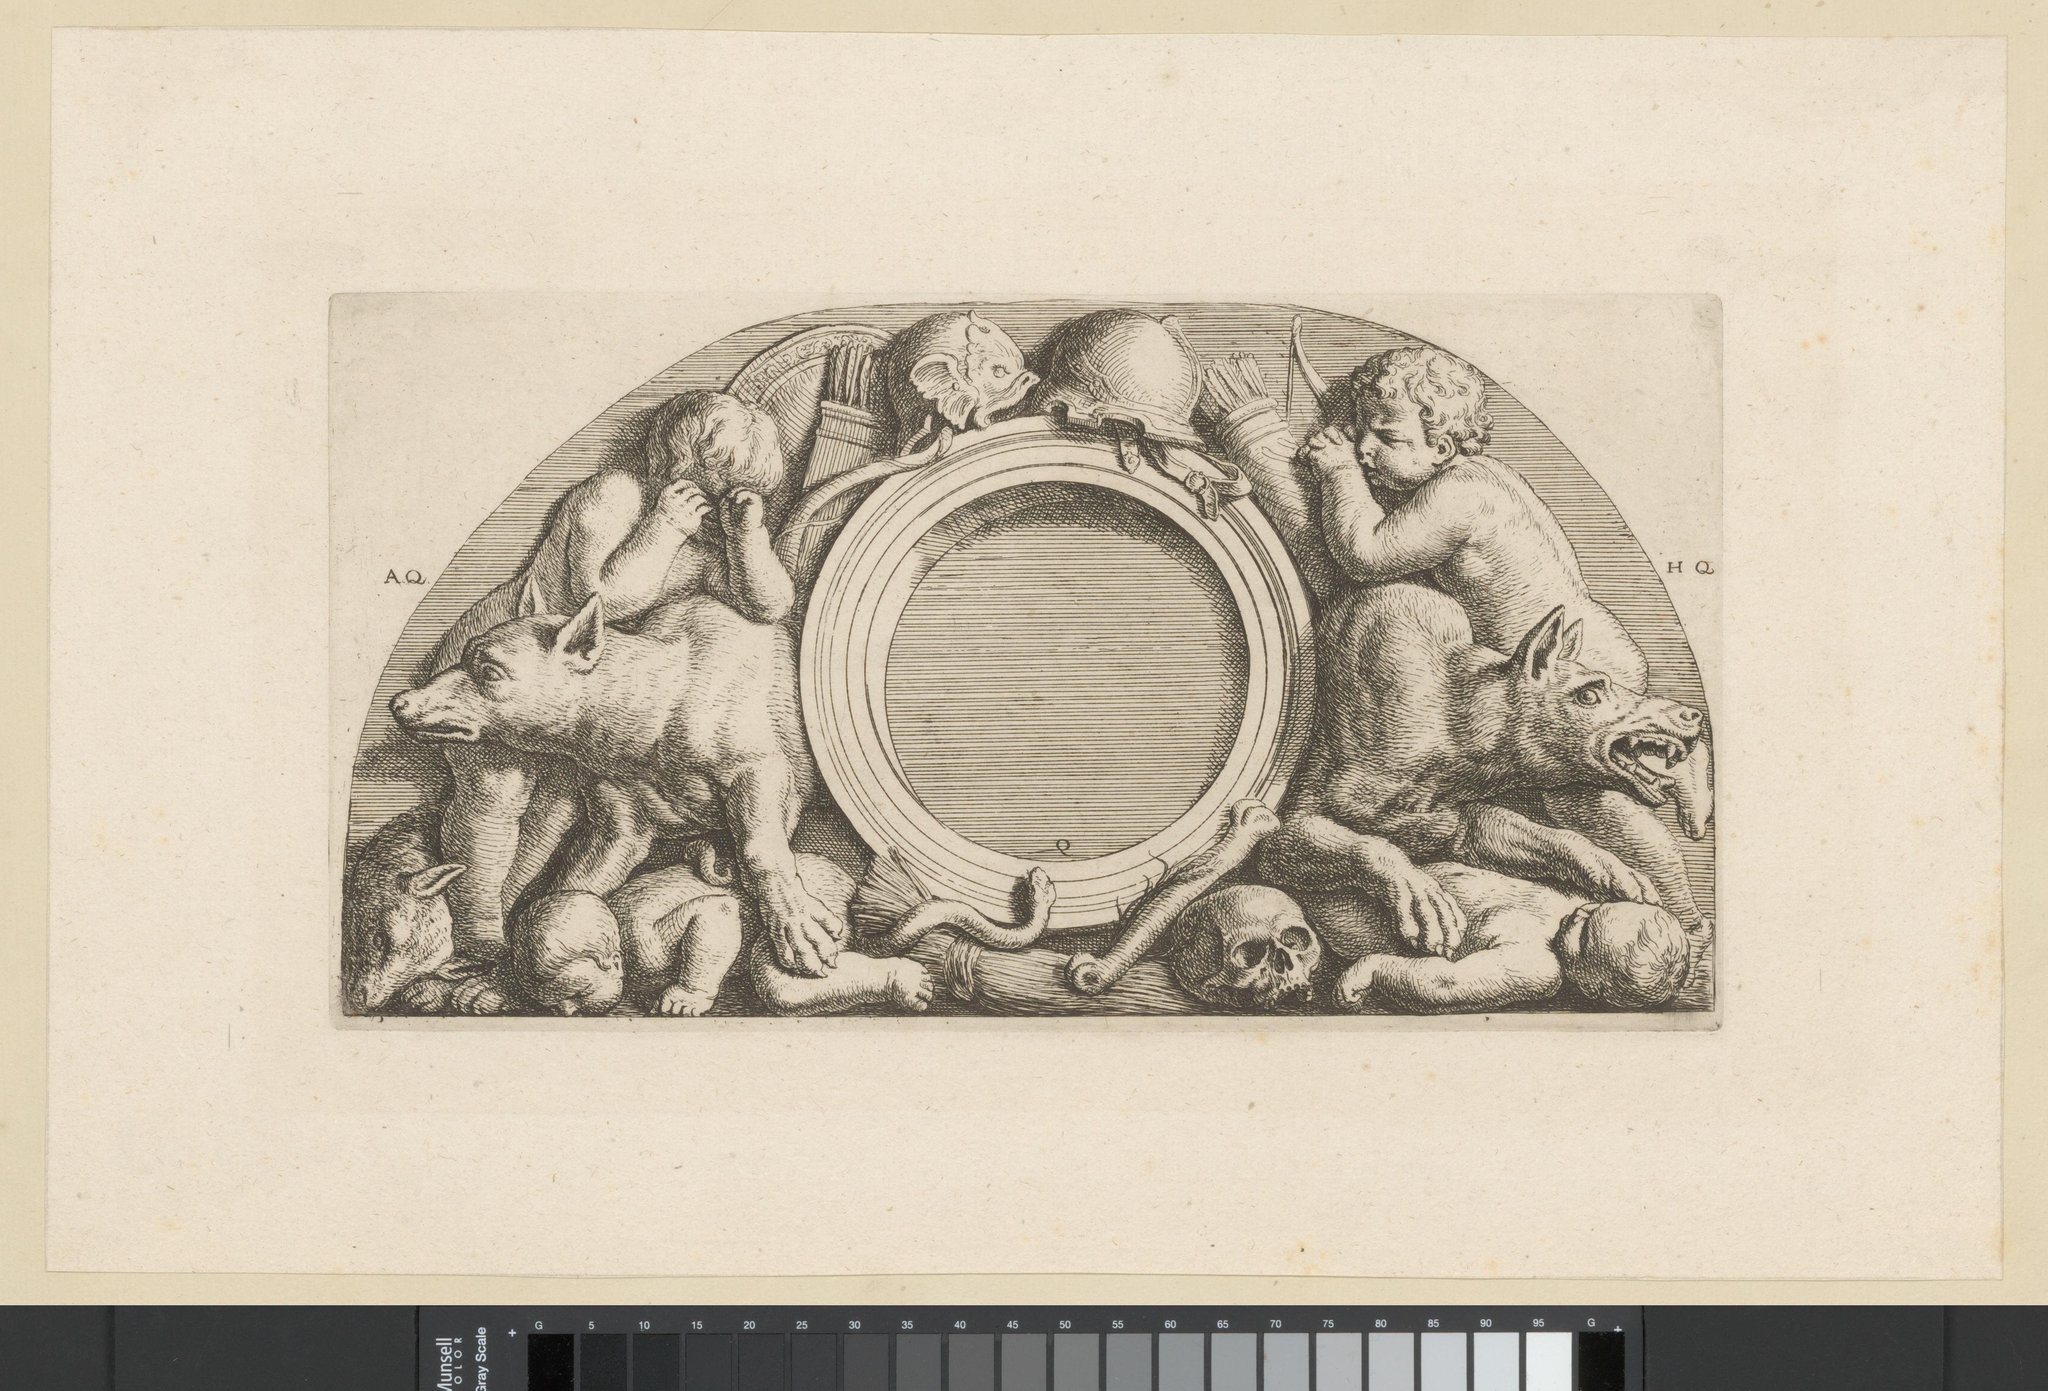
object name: print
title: Lunette met putti, wolven en wapenuitrusting in de westelijke galerij van het Stadhuis op de Dam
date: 1655-1665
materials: paper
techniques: engraving, etching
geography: amsterdam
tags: attributes of mars (with name), townhall, weeping, symbols, allegories of war; 'guerra' (ripa), cupids: 'amores', 'amoretti', 'putti'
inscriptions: collector's mark: ‘16,22’ Lugt 1641b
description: Prent gebruikt in: Prima pars. Praecipuarum effigierum ac ornamentorum, amplissimae Curiae Amstelrodamensis (…) / Het eerste deel. Van de voornaemste Statuen ende Ciraten, vant konstijck Stadhuys van Amstelredam, tmeeste in marmer gemaeckt, door Artus Quellinus, Beelthouwer der voorseyde Stadt / La Premier Partie. De plusieurs Figures et ornements, de la Maison de Ville d'Amsterdam (…). Amsterdam: Artus Quellinus (I), 1655. Zie RP-P-AO-22-1-1 voor bijhorende titelpagina. Zie RP-P-AO-22-1-2 voor bijhorend register. Zie RP-P-AO-22-1A, RP-P-AO-22-1B, RP-P-AO-22-1C, RP-P-AO-22-1D-1, RP-P-AO-22-1D-2, RP-P-AO-22-1E, RP-P-AO-22-1F, RP-P-AO-22-1G, RP-P-AO-22-1H, RP-P-AO-22-1I, RP-P-AO-22-1K-1, RP-P-AO-22-1K-2, RP-P-AO-22-1K-3, RP-P-AO-22-1K-4, RP-P-AO-22-1K-5, RP-P-AO-22-1L-1, RP-P-AO-22-1L-2, RP-P-AO-22-1M-1, RP-P-AO-22-1M-2, RP-P-AO-22-1N-1, RP-P-AO-22-1N-2, RP-P-AO-22-1N-3, RP-P-AO-22-1N-4, RP-P-AO-22-1N-5, RP-P-AO-22-1O-1, RP-P-AO-22-1O-2, RP-P-AO-22-1O-3, RP-P-AO-22-1O-4, RP-P-AO-22-1P-1, RP-P-AO-22-1P-2, RP-P-AO-22-1P-3, RP-P-AO-22-1P-4, RP-P-AO-22-1Q-1, RP-P-AO-22-1Q-2, RP-P-AO-22-1Q-3, RP-P-AO-22-1R-1, RP-P-AO-22-1R-2, RP-P-AO-22-1R-3, RP-P-AO-22-1R-4, RP-P-AO-22-1R-5, RP-P-AO-22-1S-1, RP-P-AO-22-1S-2, RP-P-AO-22-1S-3, RP-P-AO-22-1S-4, RP-P-AO-22-1S-5, RP-P-AO-22-1T-1 en RP-P-AO-22-1T-2 voor andere prenten uit deze publicatie. Zelfde staat van prent ook gebruikt in: Prima pars. Praecipuarum effigierum ac ornamentorum, amplissimae Curiae Amstelrodamensis (…) / Het eerste deel. Van de voornaemste Statuen ende Ciraten, vant konstijck Stadhuys van Amstelredam, tmeeste in marmer gemaeckt, door Artus Quellinus, Beelthouwer der voorseyde Stadt / La Premier Partie. De plusieurs Figures et ornements, de la Maison de Ville d'Amsterdam (…). Amsterdam: Frederik de Wit, 1665. Latere staat van prent ook gebruikt in: Architecture peinture et sculpture de la Maison de Ville d'Amsterdam, representee en CIX. figures en taille-douce (…). Amsterdam: David Mortier, 1719. En in: Architecture peinture et sculpture de la Maison de Ville d'Amsterdam, representee en CIX. figures en taille-douce (…). Amsterdam: Gerard Valck, 1719. En in: Bouw schilder en beeldhouwkonst, van het Stadhuis te Amsteldam, vertoont in CIX figuuren (…). Amsterdam: Covens & Mortier & Covens Jr., s.a. (1774-1783).